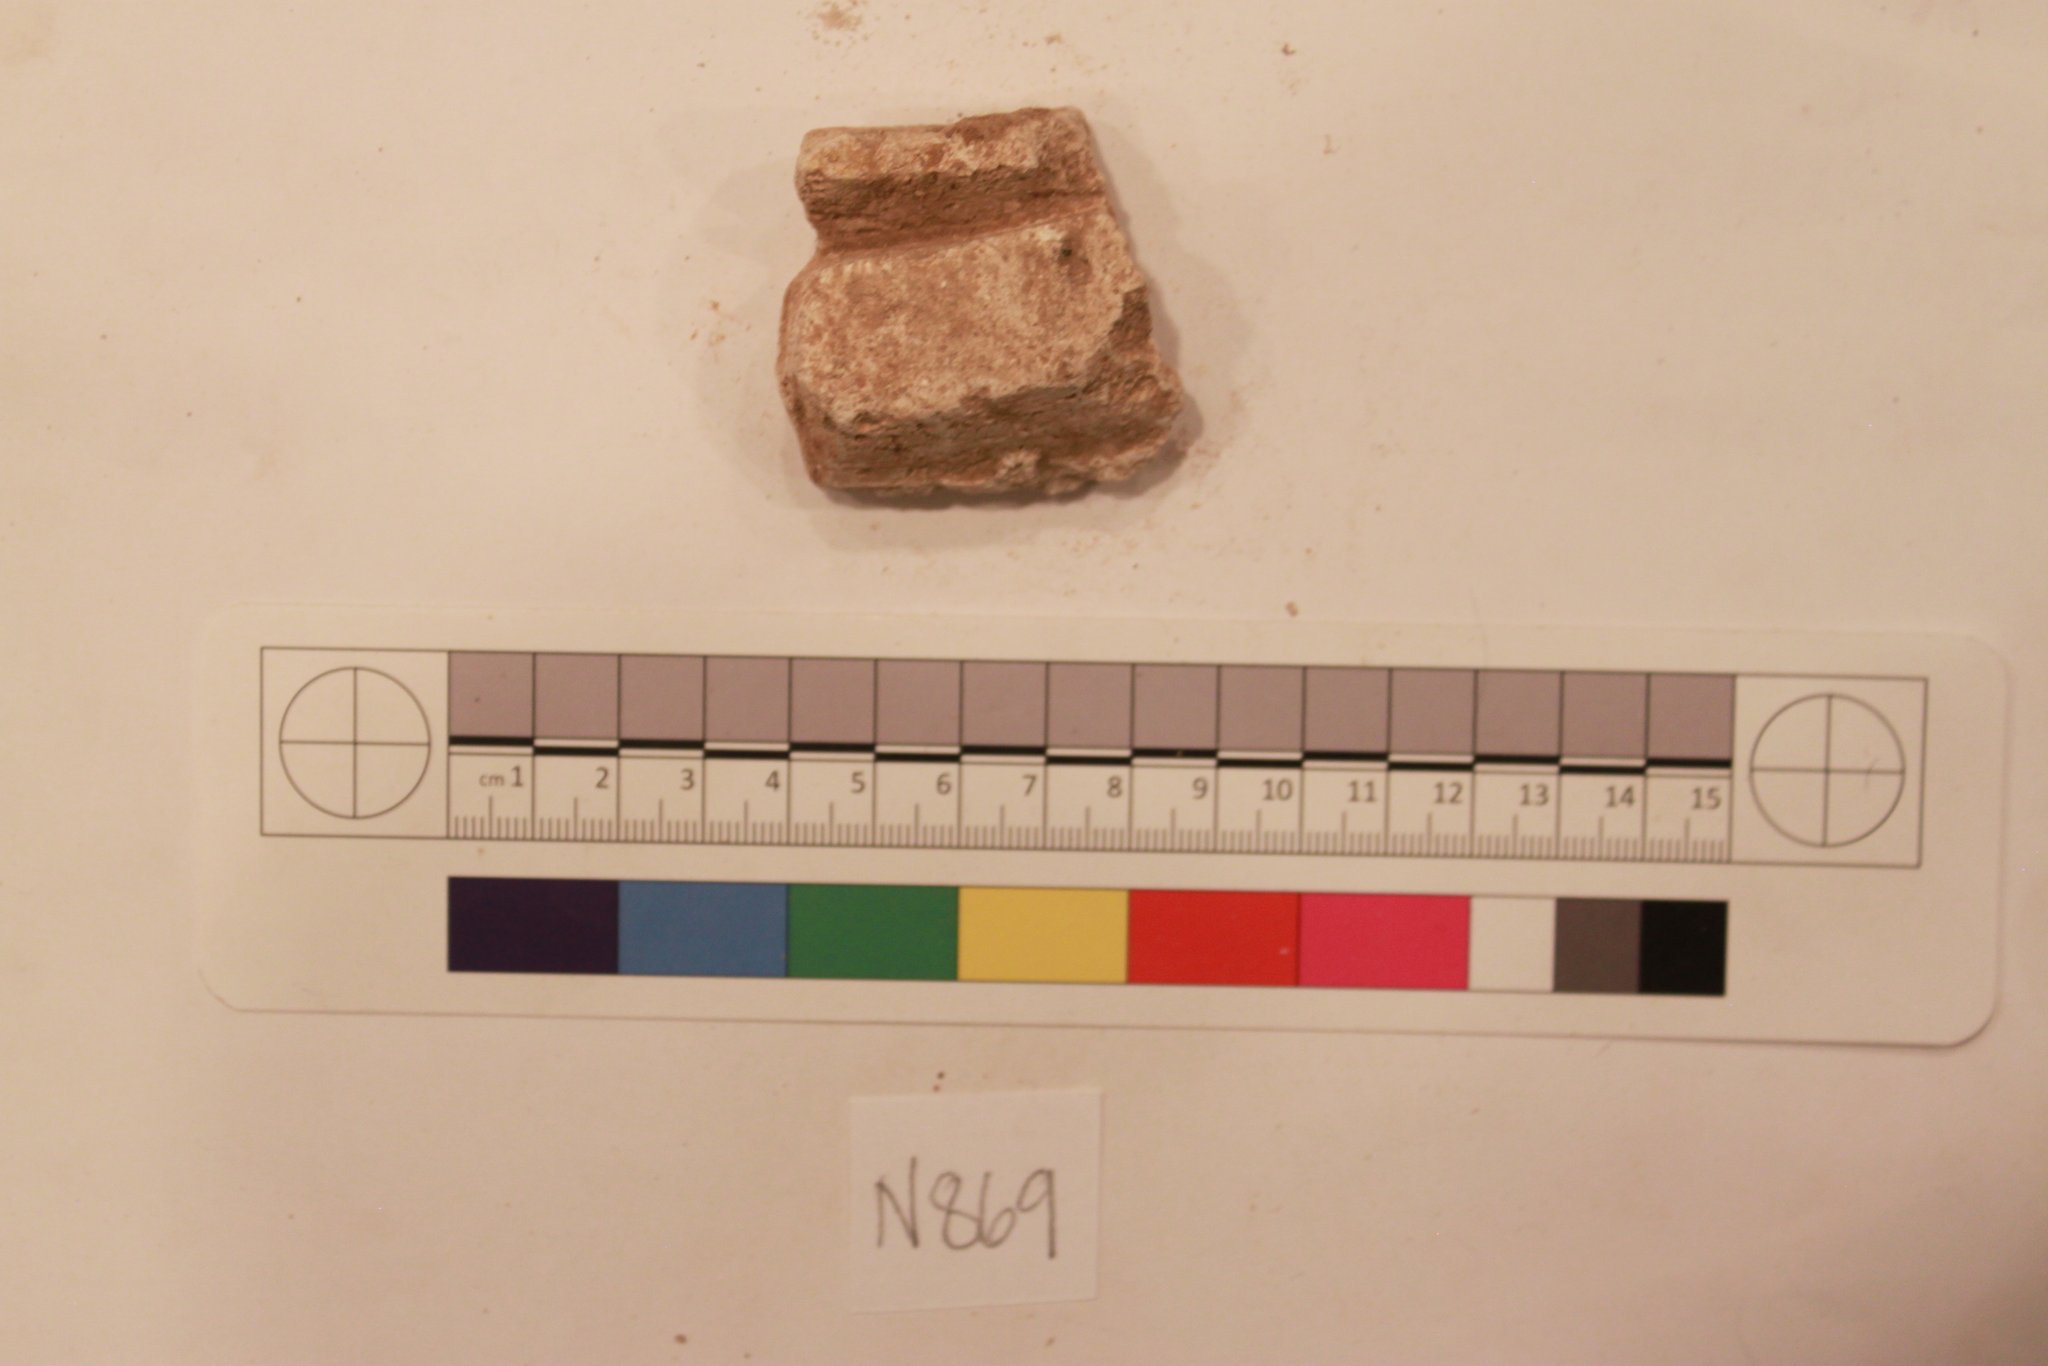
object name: fragment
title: Stucco Fragment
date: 701-1200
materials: plaster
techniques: carving, painting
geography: iran